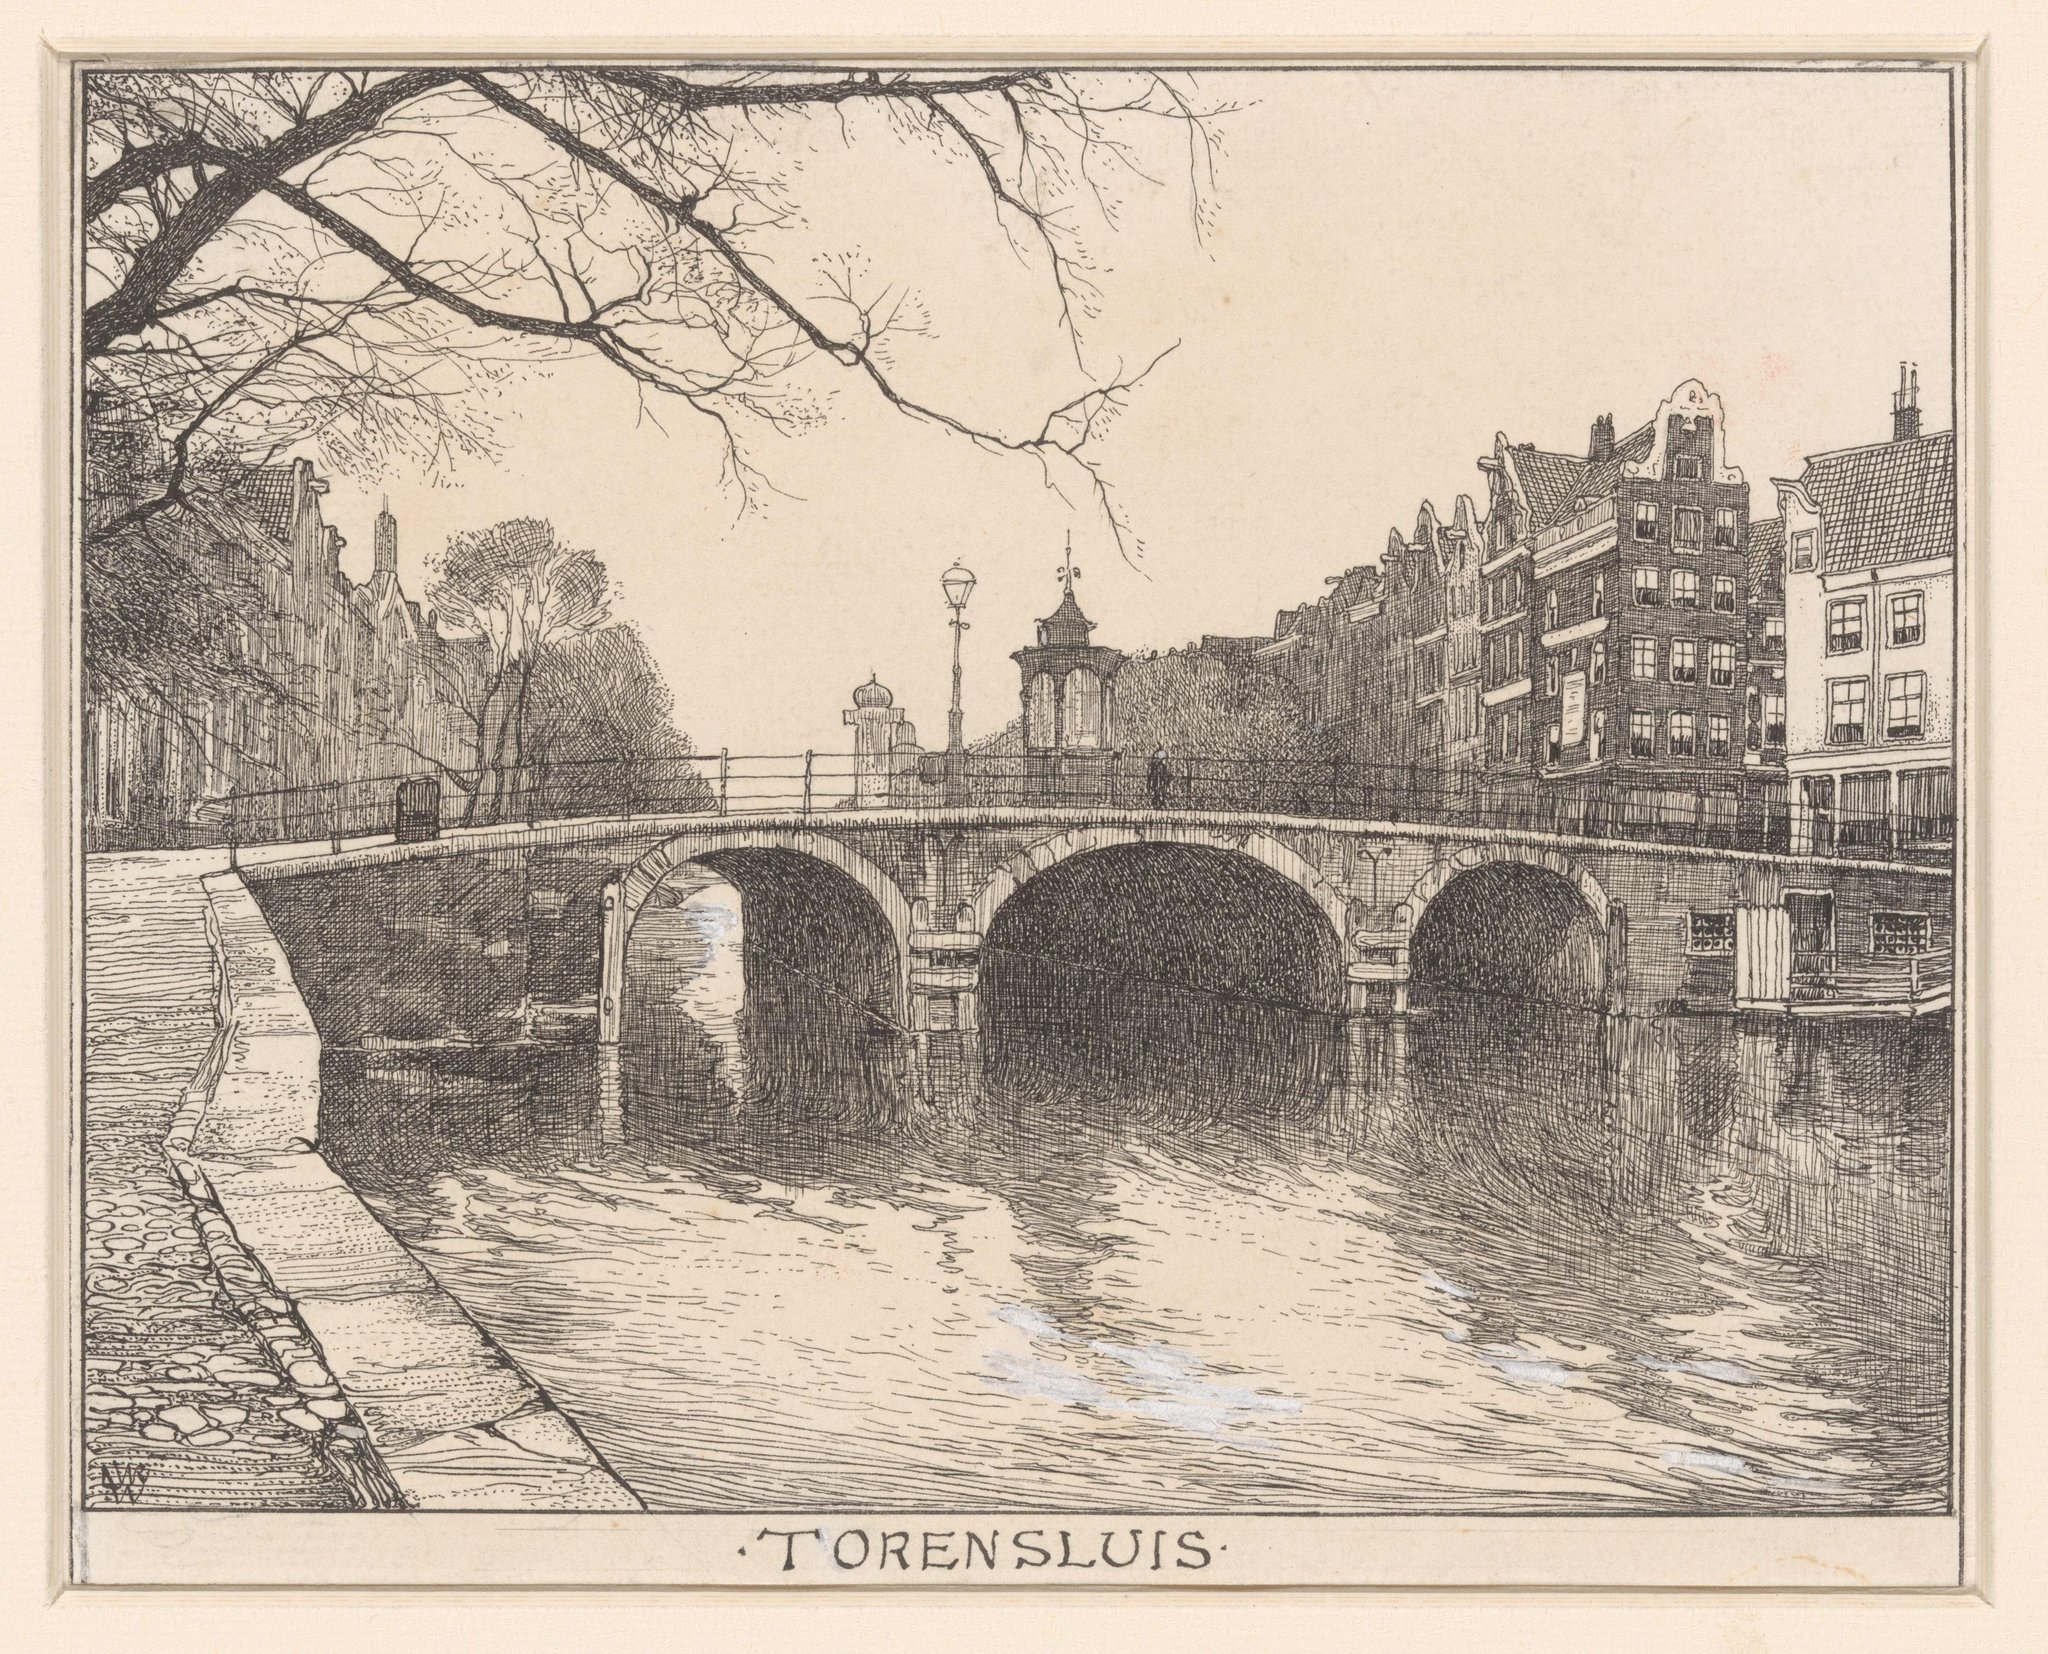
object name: drawing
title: Torensluis te Amsterdam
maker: willem wenckebach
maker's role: designer, draughtsman, painter, print maker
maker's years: 1860-1937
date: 1870-1926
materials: paint, ink, paper, pencil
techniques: pen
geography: amsterdam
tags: canals, waters (in city), amsterdam